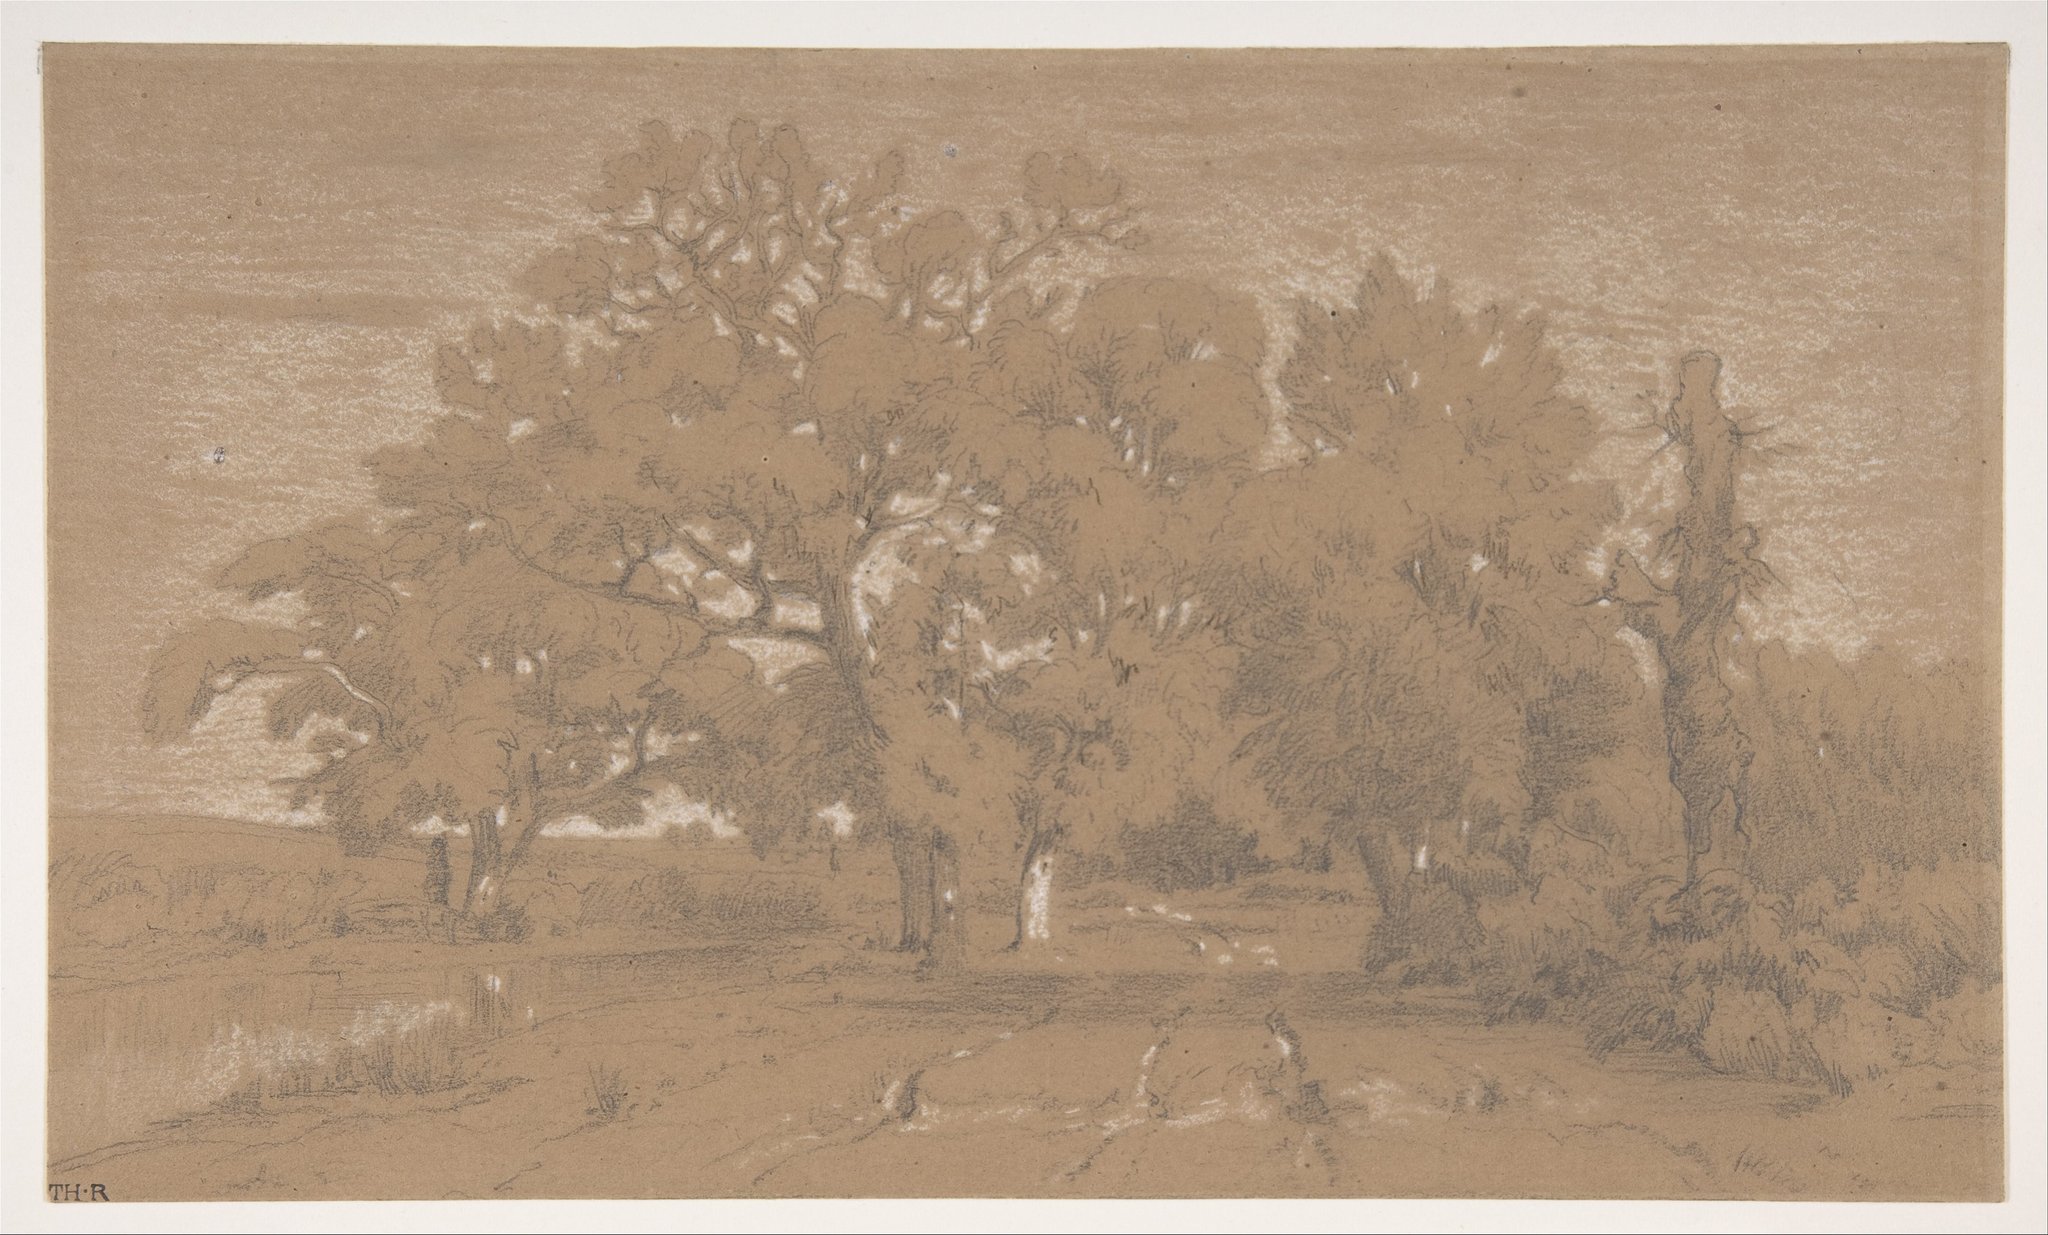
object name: drawing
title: Landscape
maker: théodore rousseau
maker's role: artist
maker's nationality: french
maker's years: 1812-1867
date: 1842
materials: chalk, graphite, paper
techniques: heightening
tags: landscapes,trees